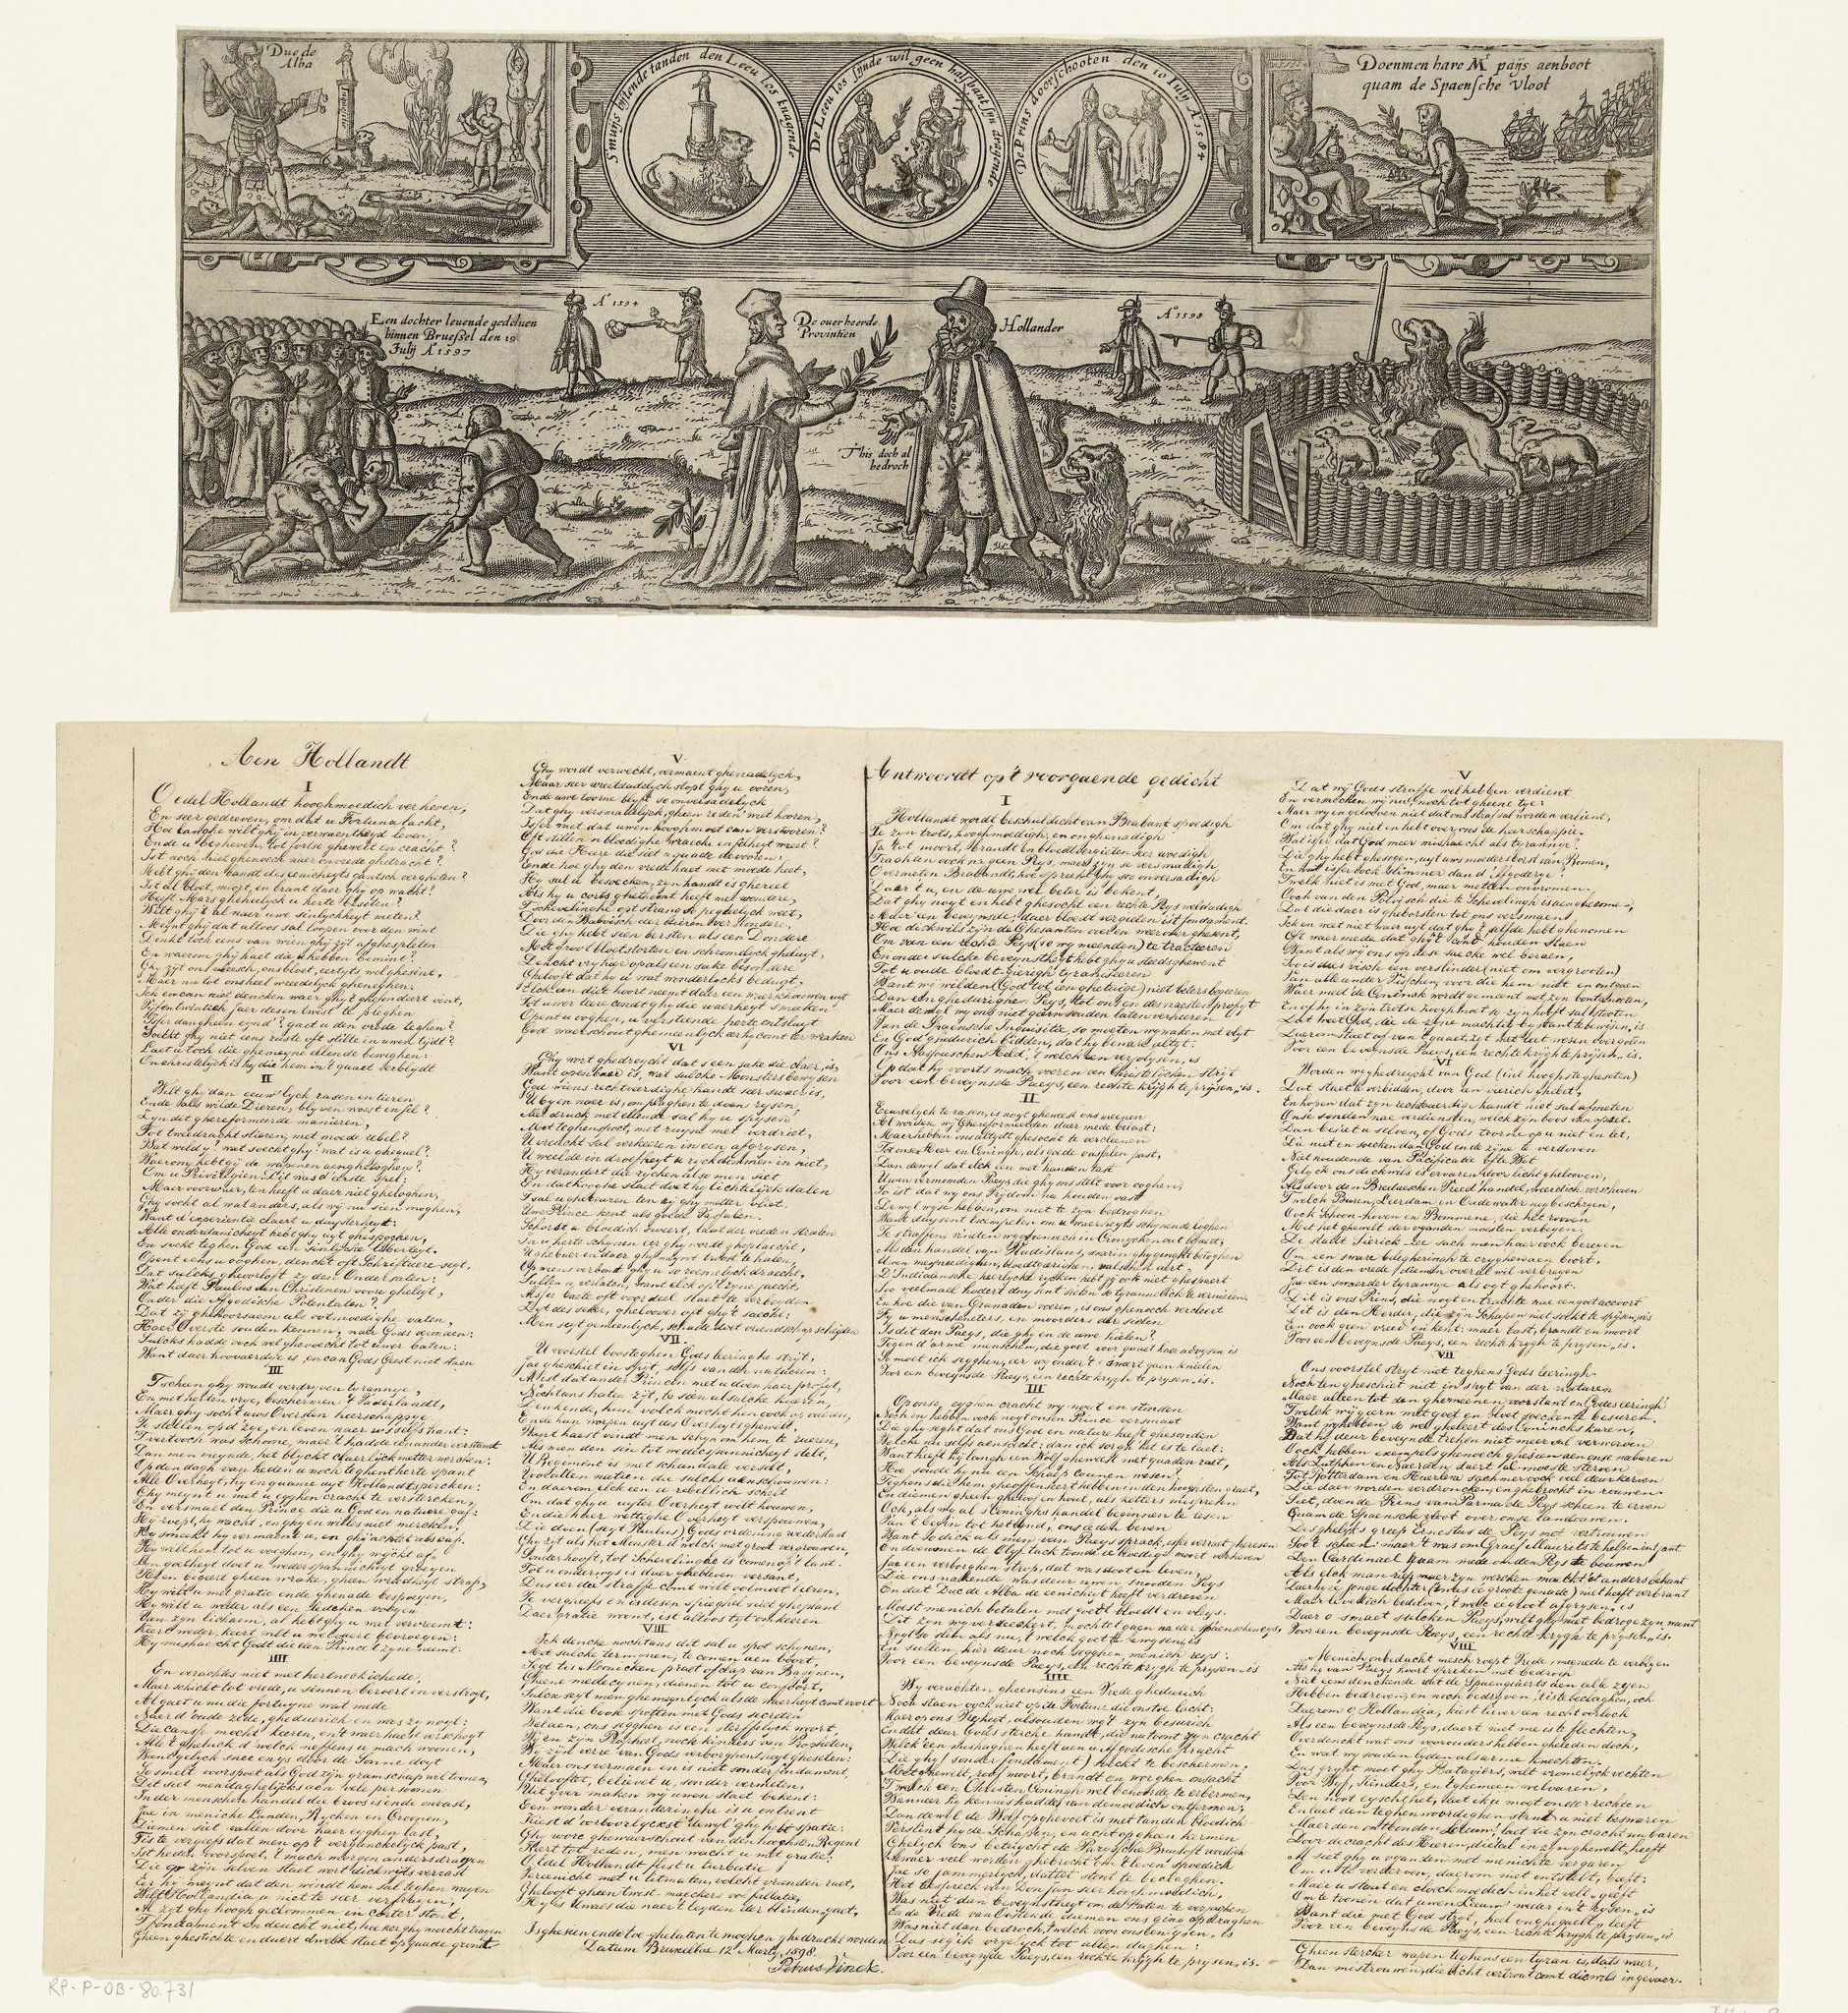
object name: print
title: Allegorie op de bedrieglijke vredesvoorstellen in 1598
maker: Anonymous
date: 1598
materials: ink, paper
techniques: etching, pen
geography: northern netherlands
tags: delft, william i (prince of orange), the hague, maurice (prince of orange), fernando álvarez de toledo (3rd duke of alba), brussels, peace negotiations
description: Allegorische voorstelling tegen de vredesvoorstellen in het jaar 1598. In de centrale voorstelling de personificatie van de Overheerde Provintien, met Janushoofd in monnikspij met olijftak staande voor de Hollander met de Nederlandse Leeuw. Links wordt Anneken van den Hove te Brussel levend begraven wordt (1597), rechts de Nederlandse Leeuw met enkele schapen in de Hollandse Tuin. Op de achtergrond de aanslagen op prins Maurits in 1594 door Michien Renichon of Pierre du Four en in 1598 door Pieter Panne. Bovenaan aparte cartouches met kleine scènes met: de tirannie onder de hertog van Alva, een muis knaagt de touwen door waarmee de Nederlandse Leeuw aan de zuil van de Inquisitie is gebonden, de vrije Nederlandse Leeuw wil geen halsband meer om, de moord op Willem van Oranje in 1584 en de valse vredesvoorstellen aan koningin Elizabeth I met op de achtergrond de Spaanse Armada van 1588. Bij de prent een afschrift van de bijbehorende tekst overgenomen van een ander exemplaar, 4 kolommen in het Nederlands.